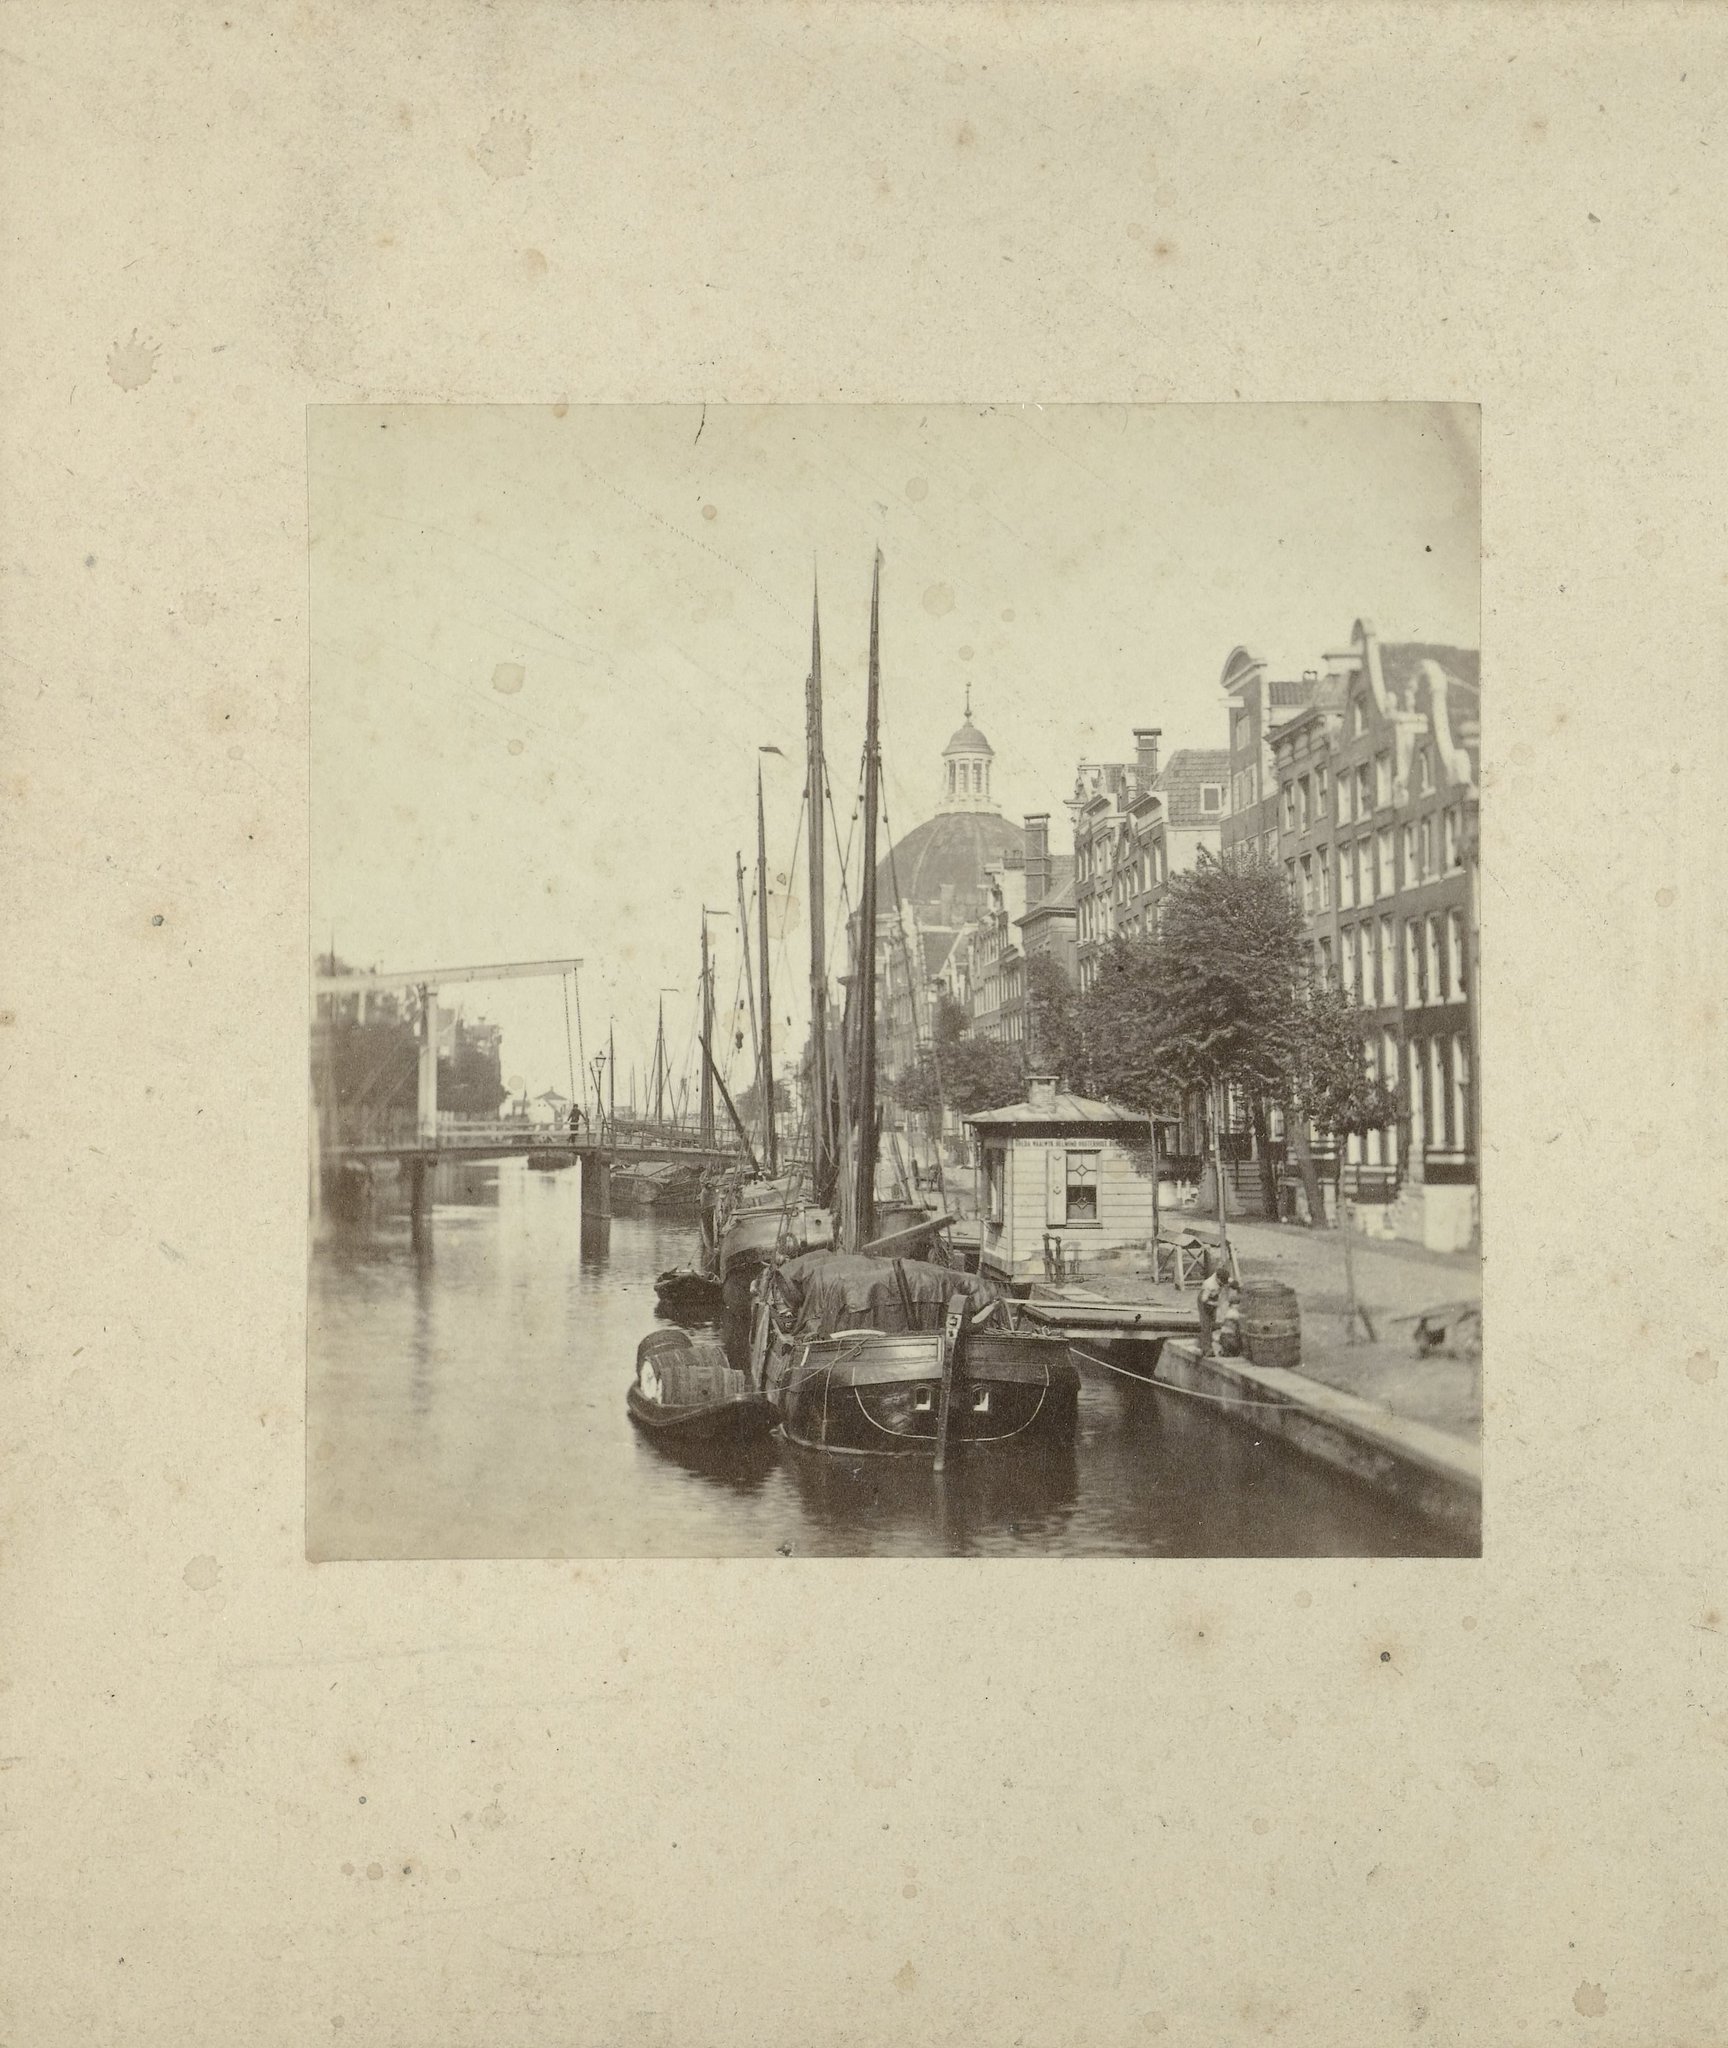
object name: photograph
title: Singel bij de Luthersche Nieuwe Kerk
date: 1860-1875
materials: cardboard, paper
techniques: albumen print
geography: amsterdam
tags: church (exterior), canals, waters (in city)